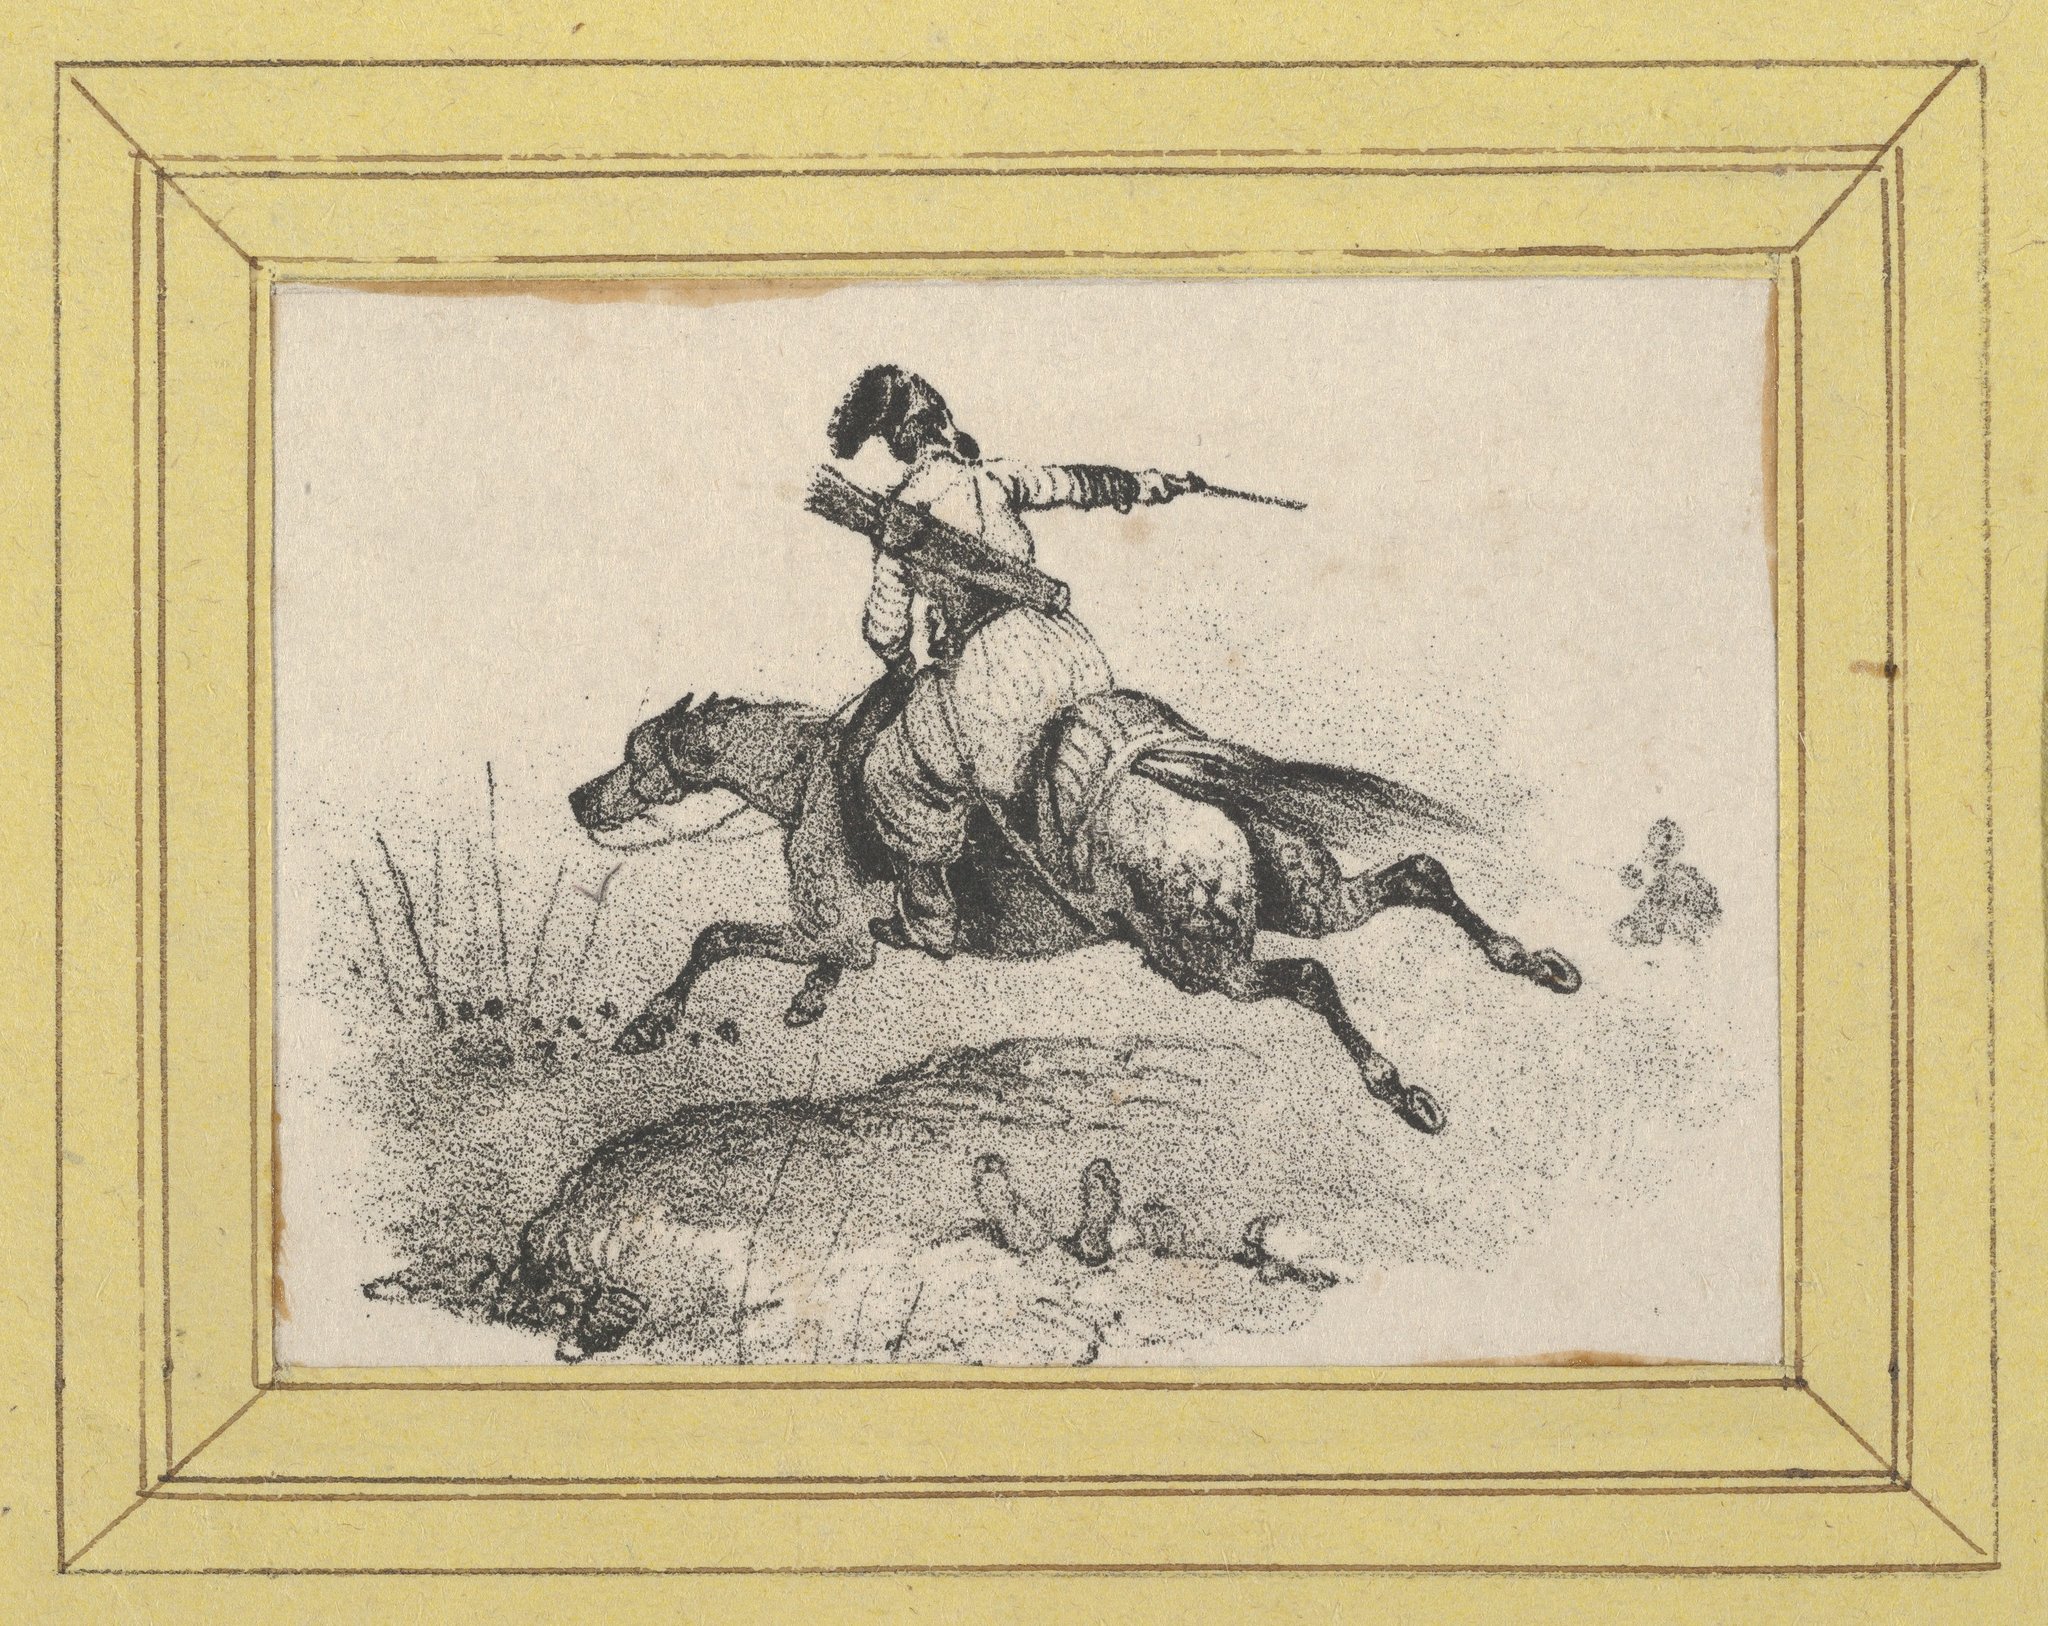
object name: print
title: Soldier on galloping horse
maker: victor adam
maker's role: artist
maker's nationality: french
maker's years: 1801-1866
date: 1834-1866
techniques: lithograph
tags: soldiers,men,horses